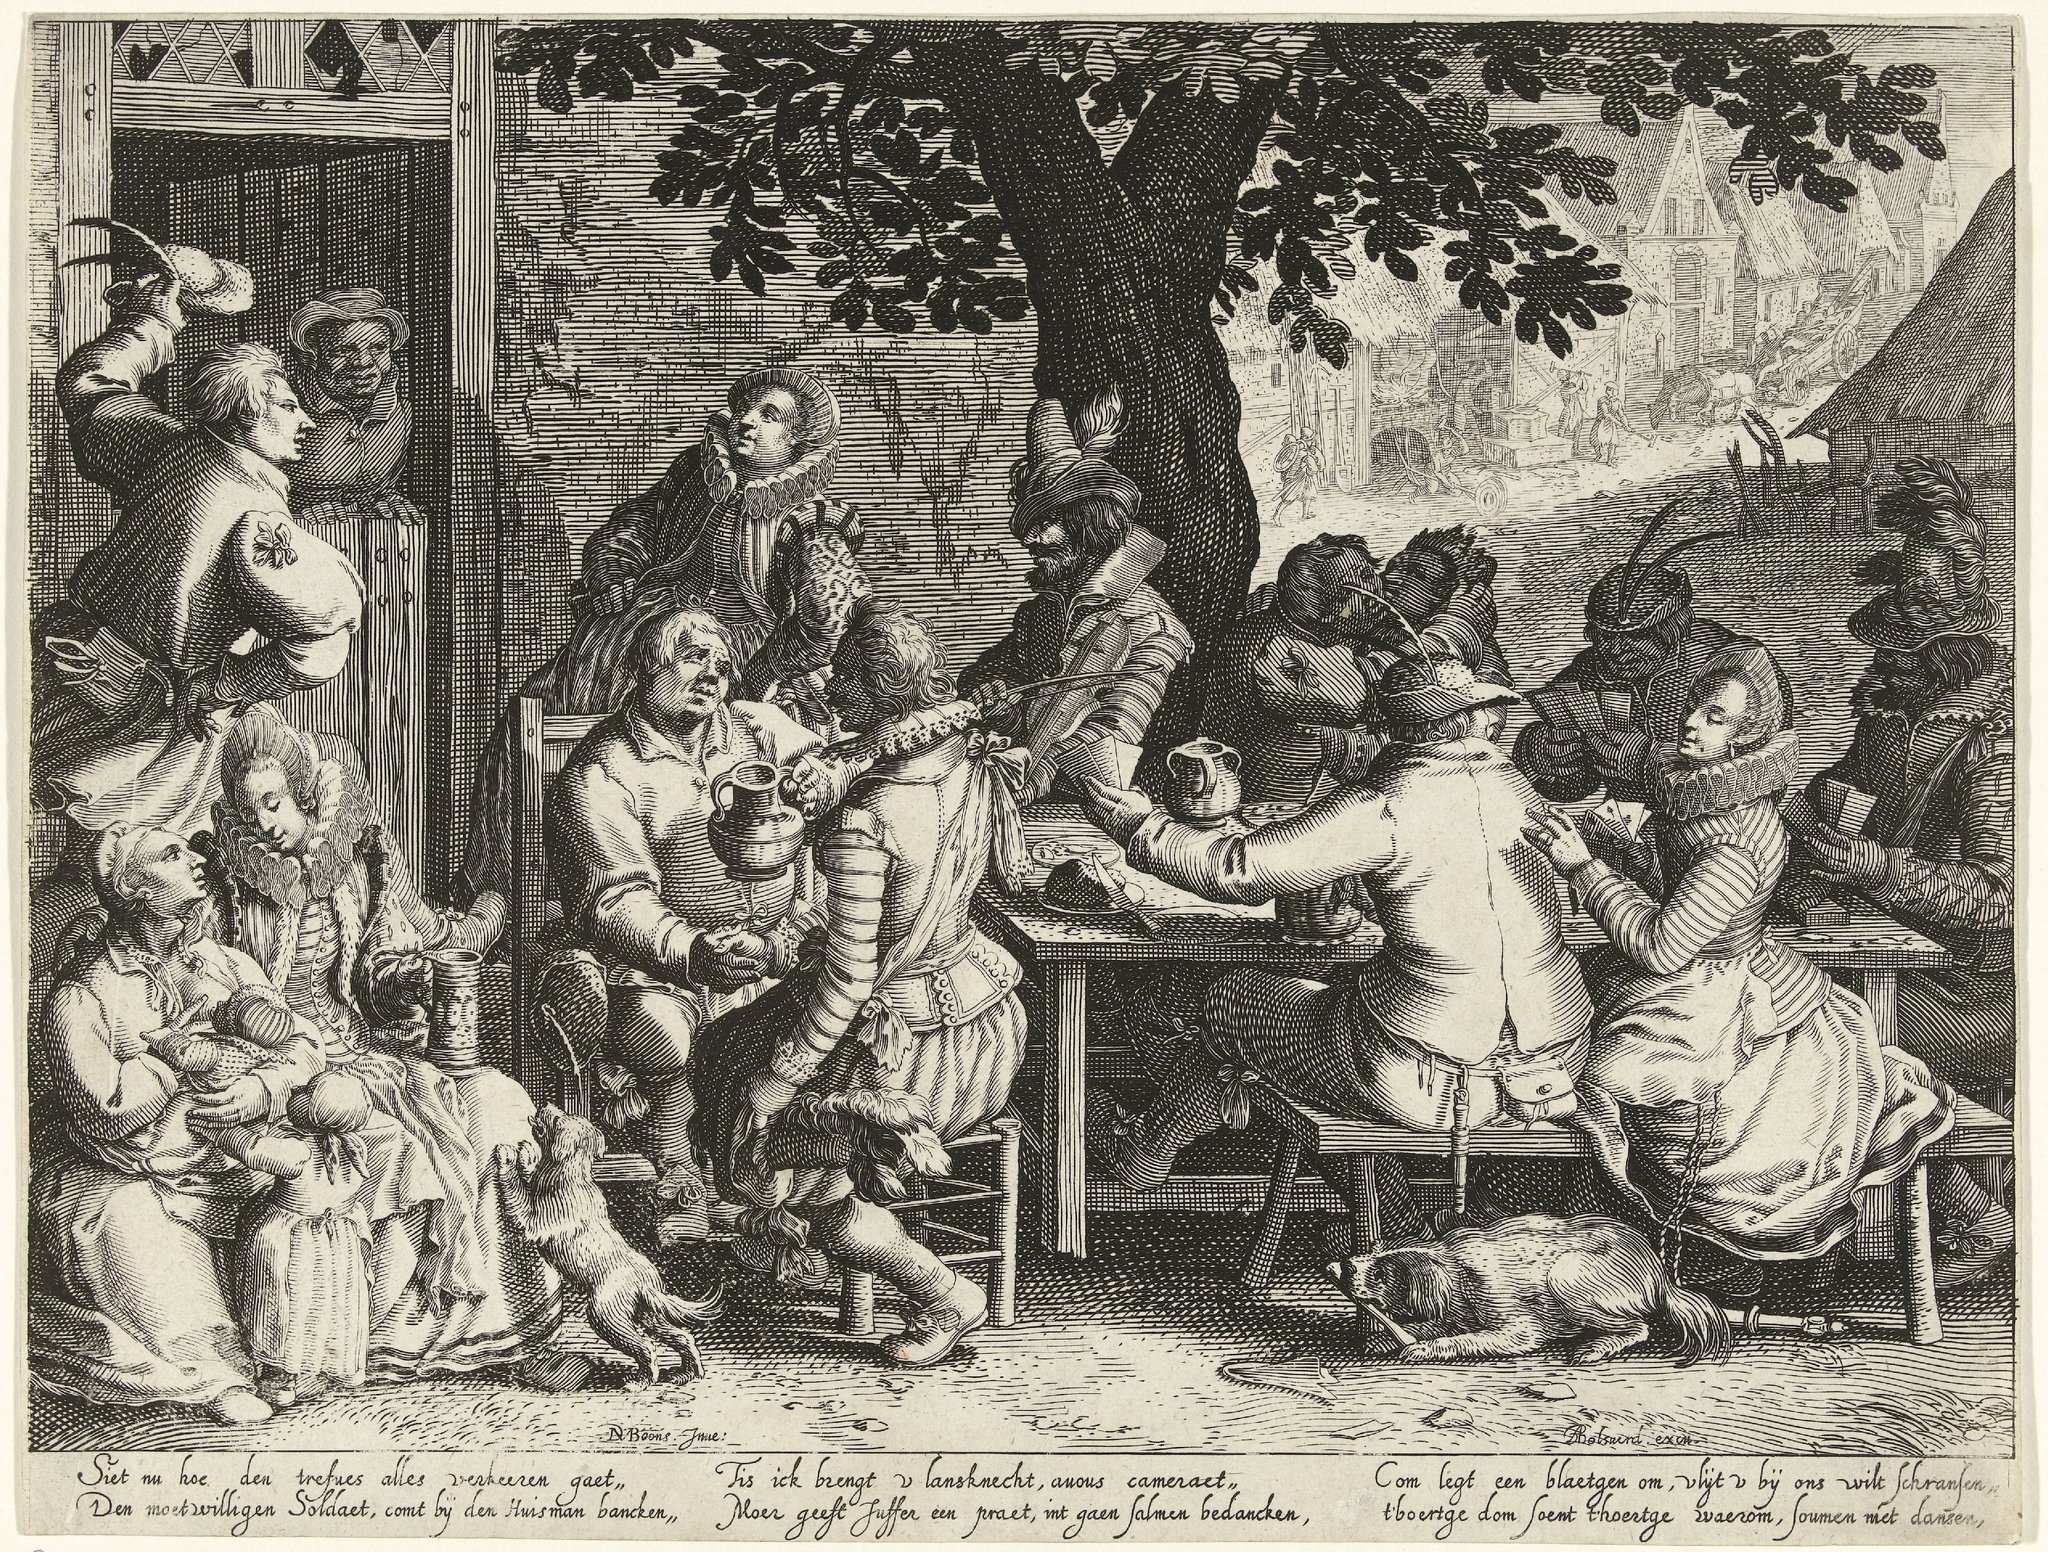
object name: print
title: Dankzij het Bestand leven boeren en soldaten vreedzaam samen, 1609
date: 1610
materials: paper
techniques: engraving, etching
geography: northern netherlands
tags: blessings of peace, fight between farmers and soldiers, pavement, terrace in front of inn or restaurant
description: Dankzij het Bestand (de Trêves) kunnen boeren en soldaten nu vreedzaam met elkaar samenleven, 1609. Boeren en soldaten vermaken zich met drinken, dansen en muziek maken op het terras voor een herberg. Met onderschrift van 3 verzen van 2 regels in het Nederlands. Onderdeel van de serie van 4 prenten over de strijd tussen boeren en soldaten tijdens de oorlog.